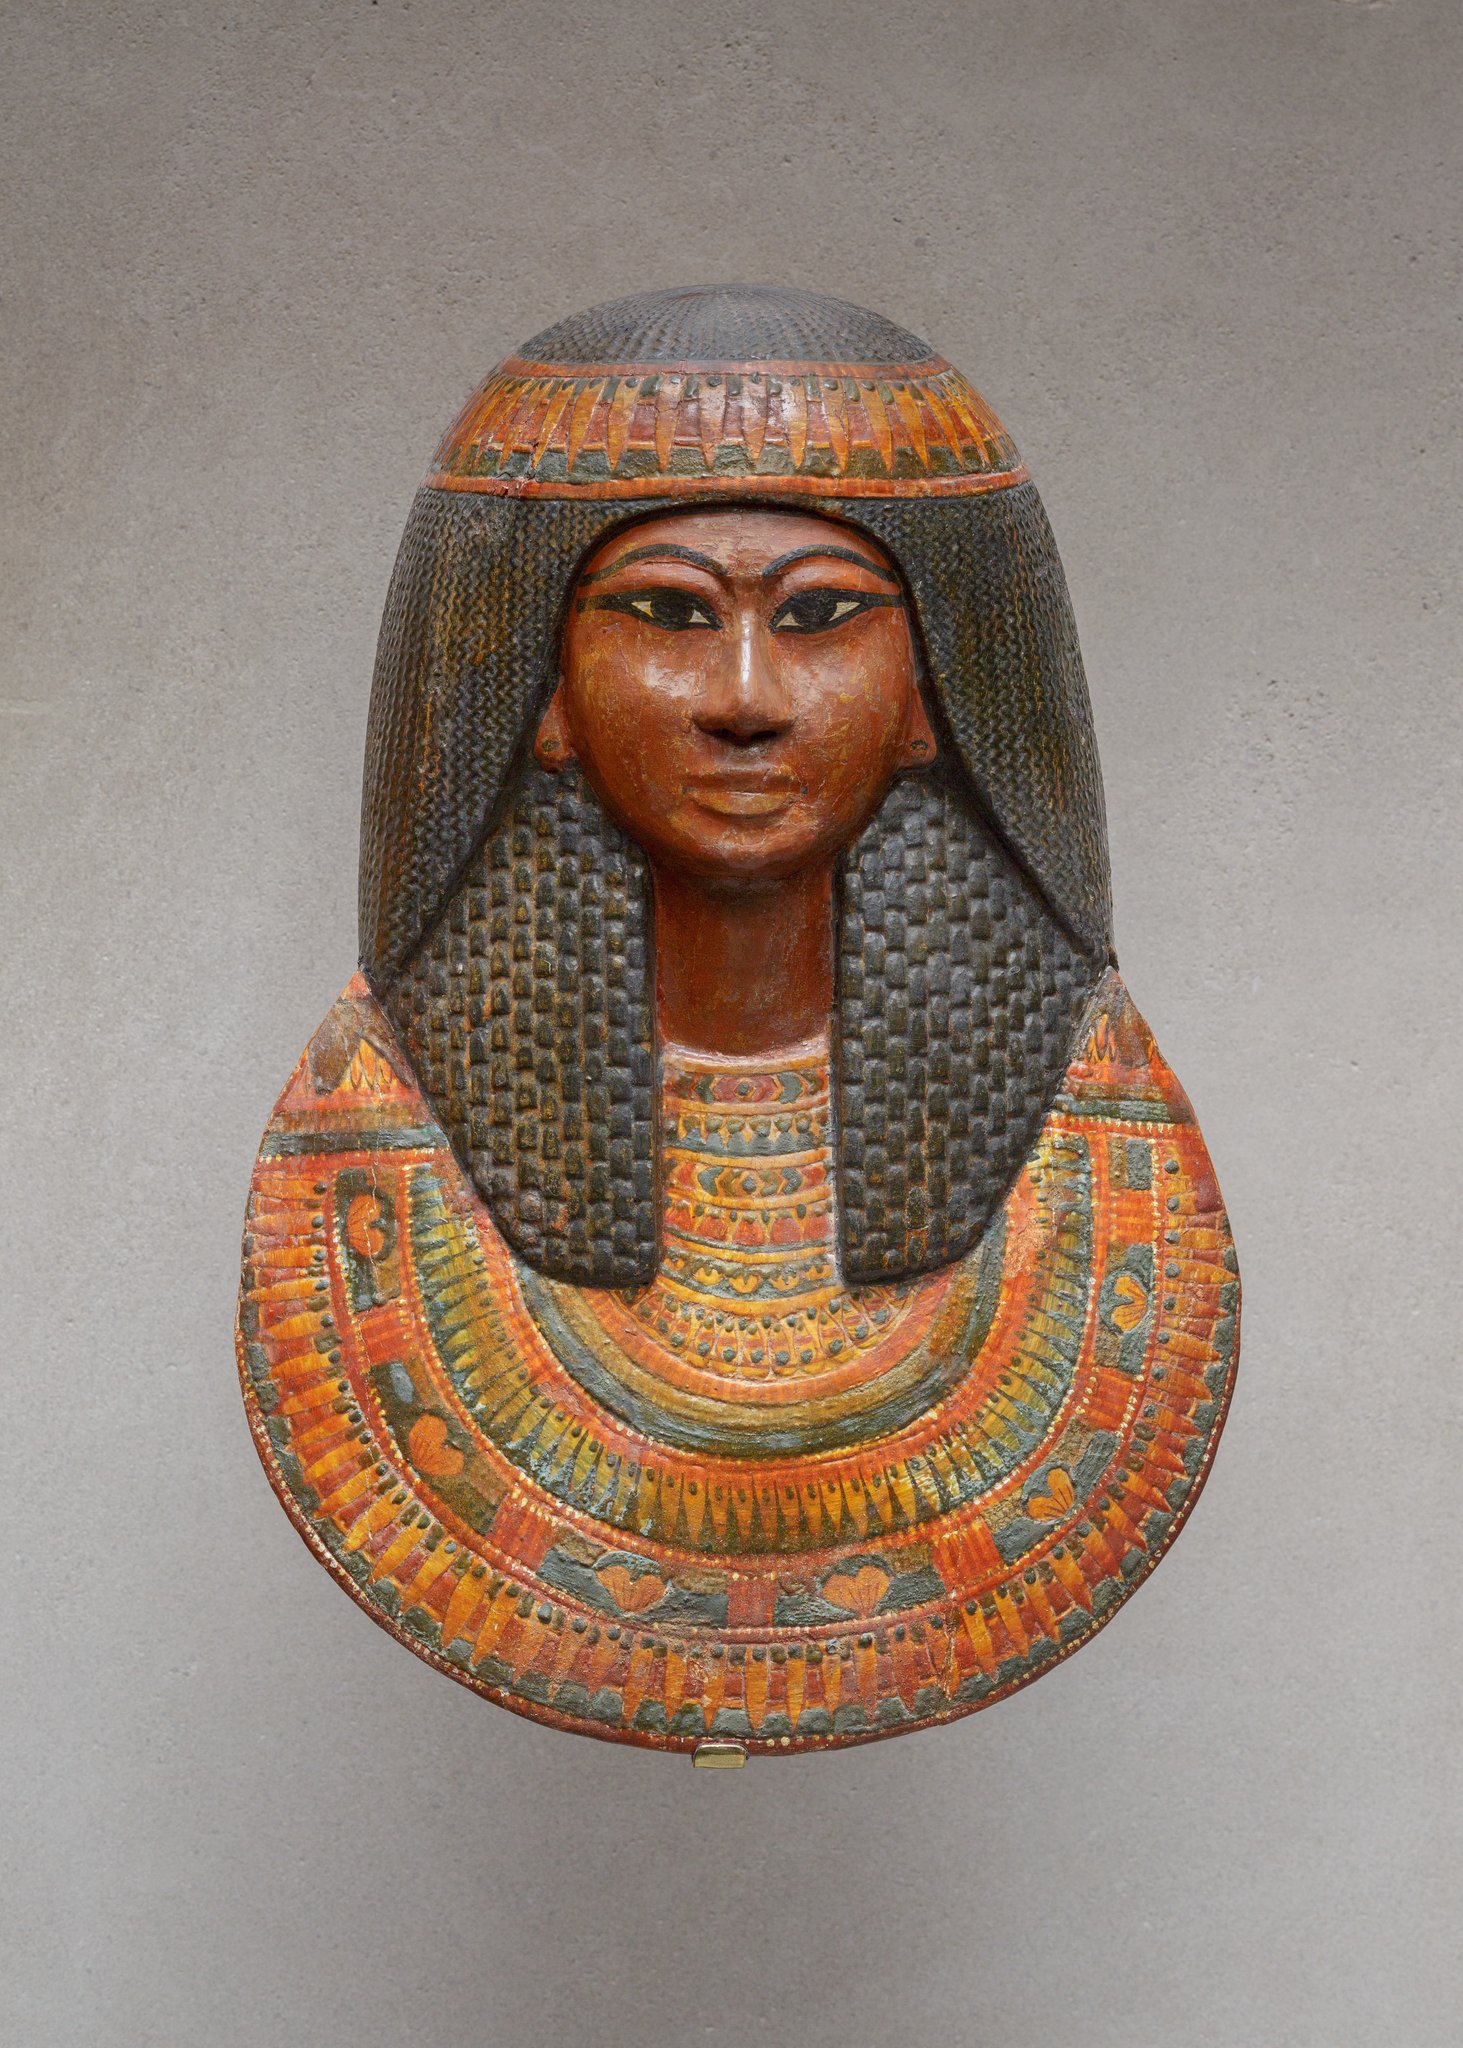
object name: mask, khonsu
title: Mummy Mask of Khonsu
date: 1279-1213 BCE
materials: wood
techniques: painting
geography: egypt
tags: masks,men,portraits